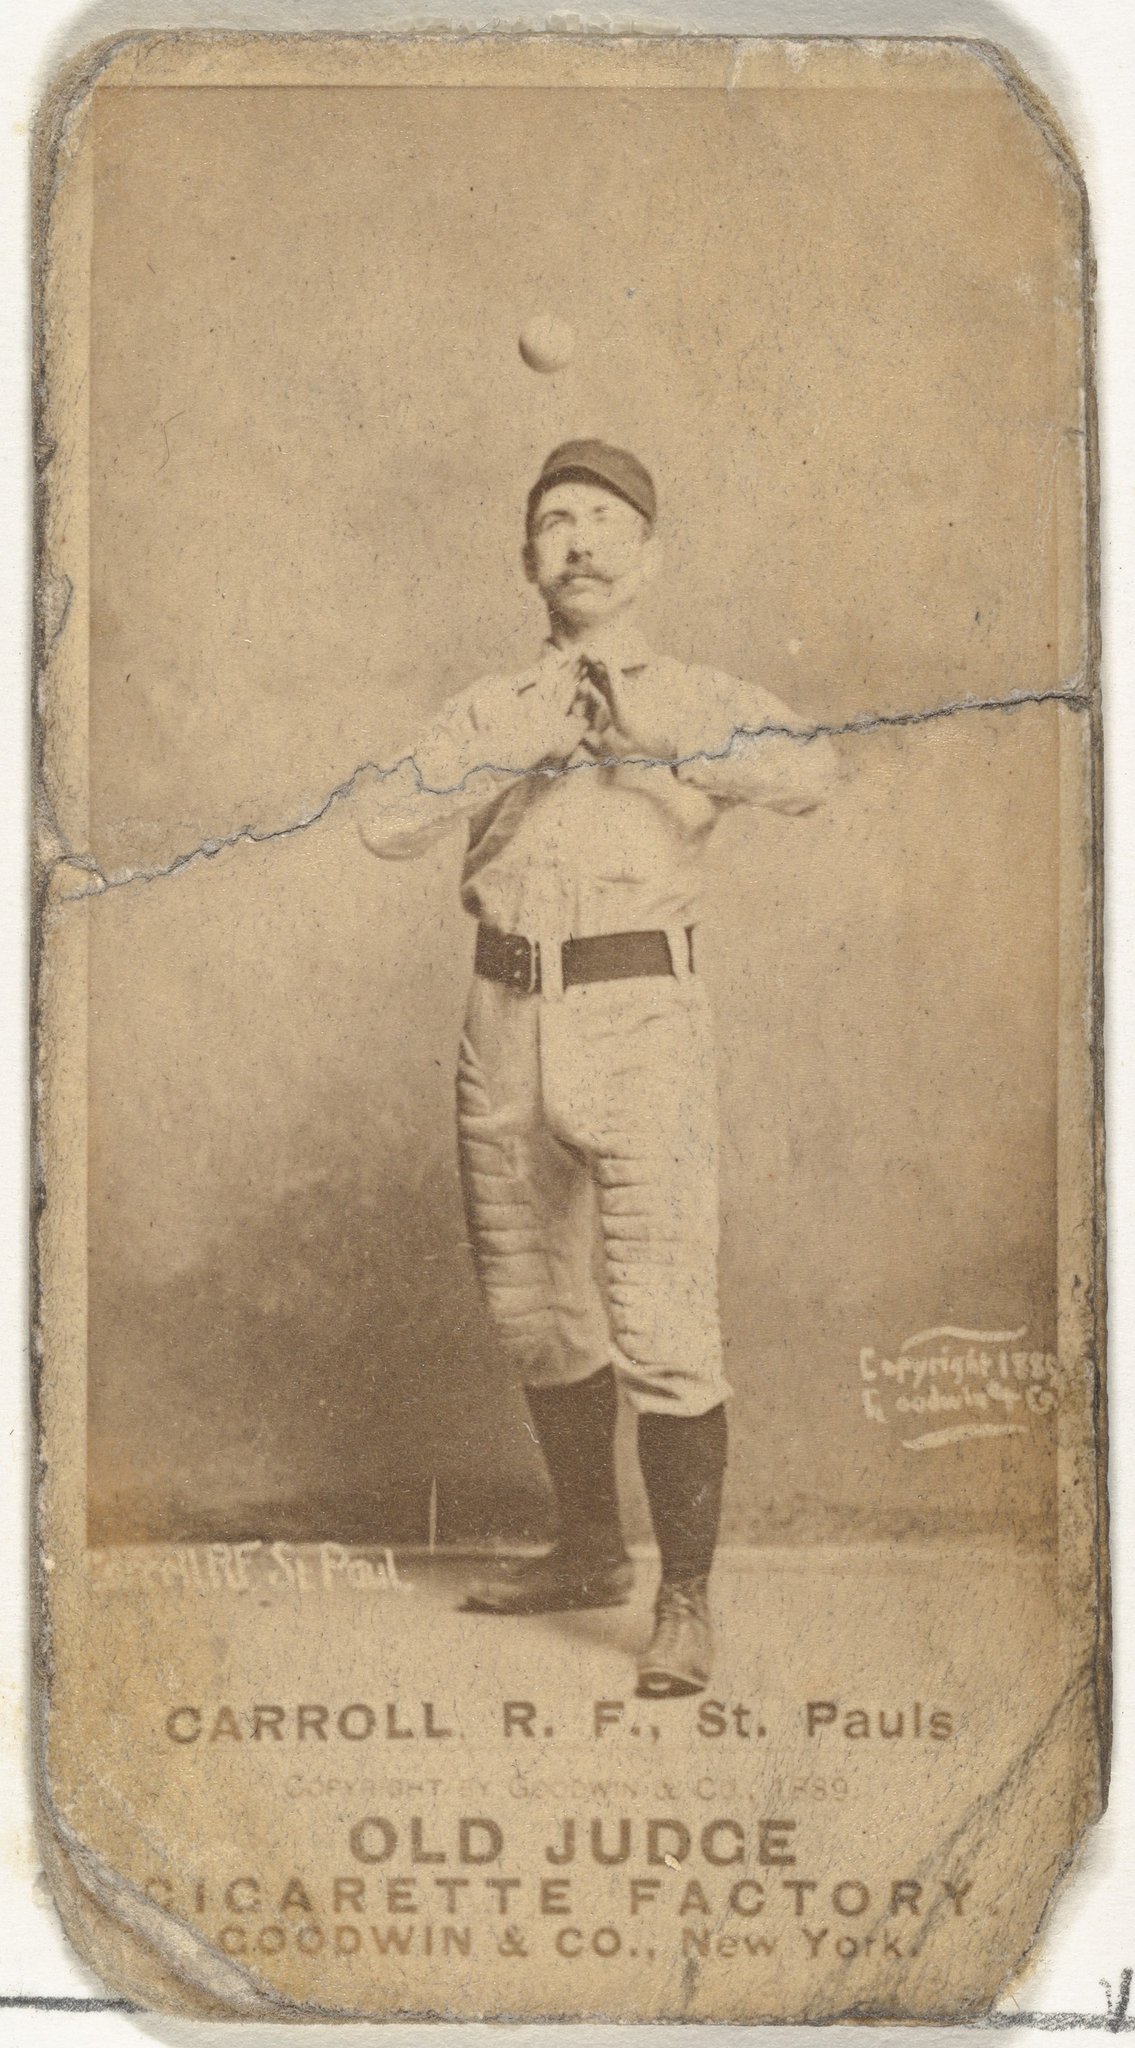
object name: baseball card, photograph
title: John E. "Scrappy" Carroll, Right Field, St. Paul Apostles, from the Old Judge series (N172) for Old Judge Cigarettes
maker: goodwin & company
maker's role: publisher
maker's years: 1850-1950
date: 1889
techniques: albumen silver print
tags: men,portraits,baseball,athletes